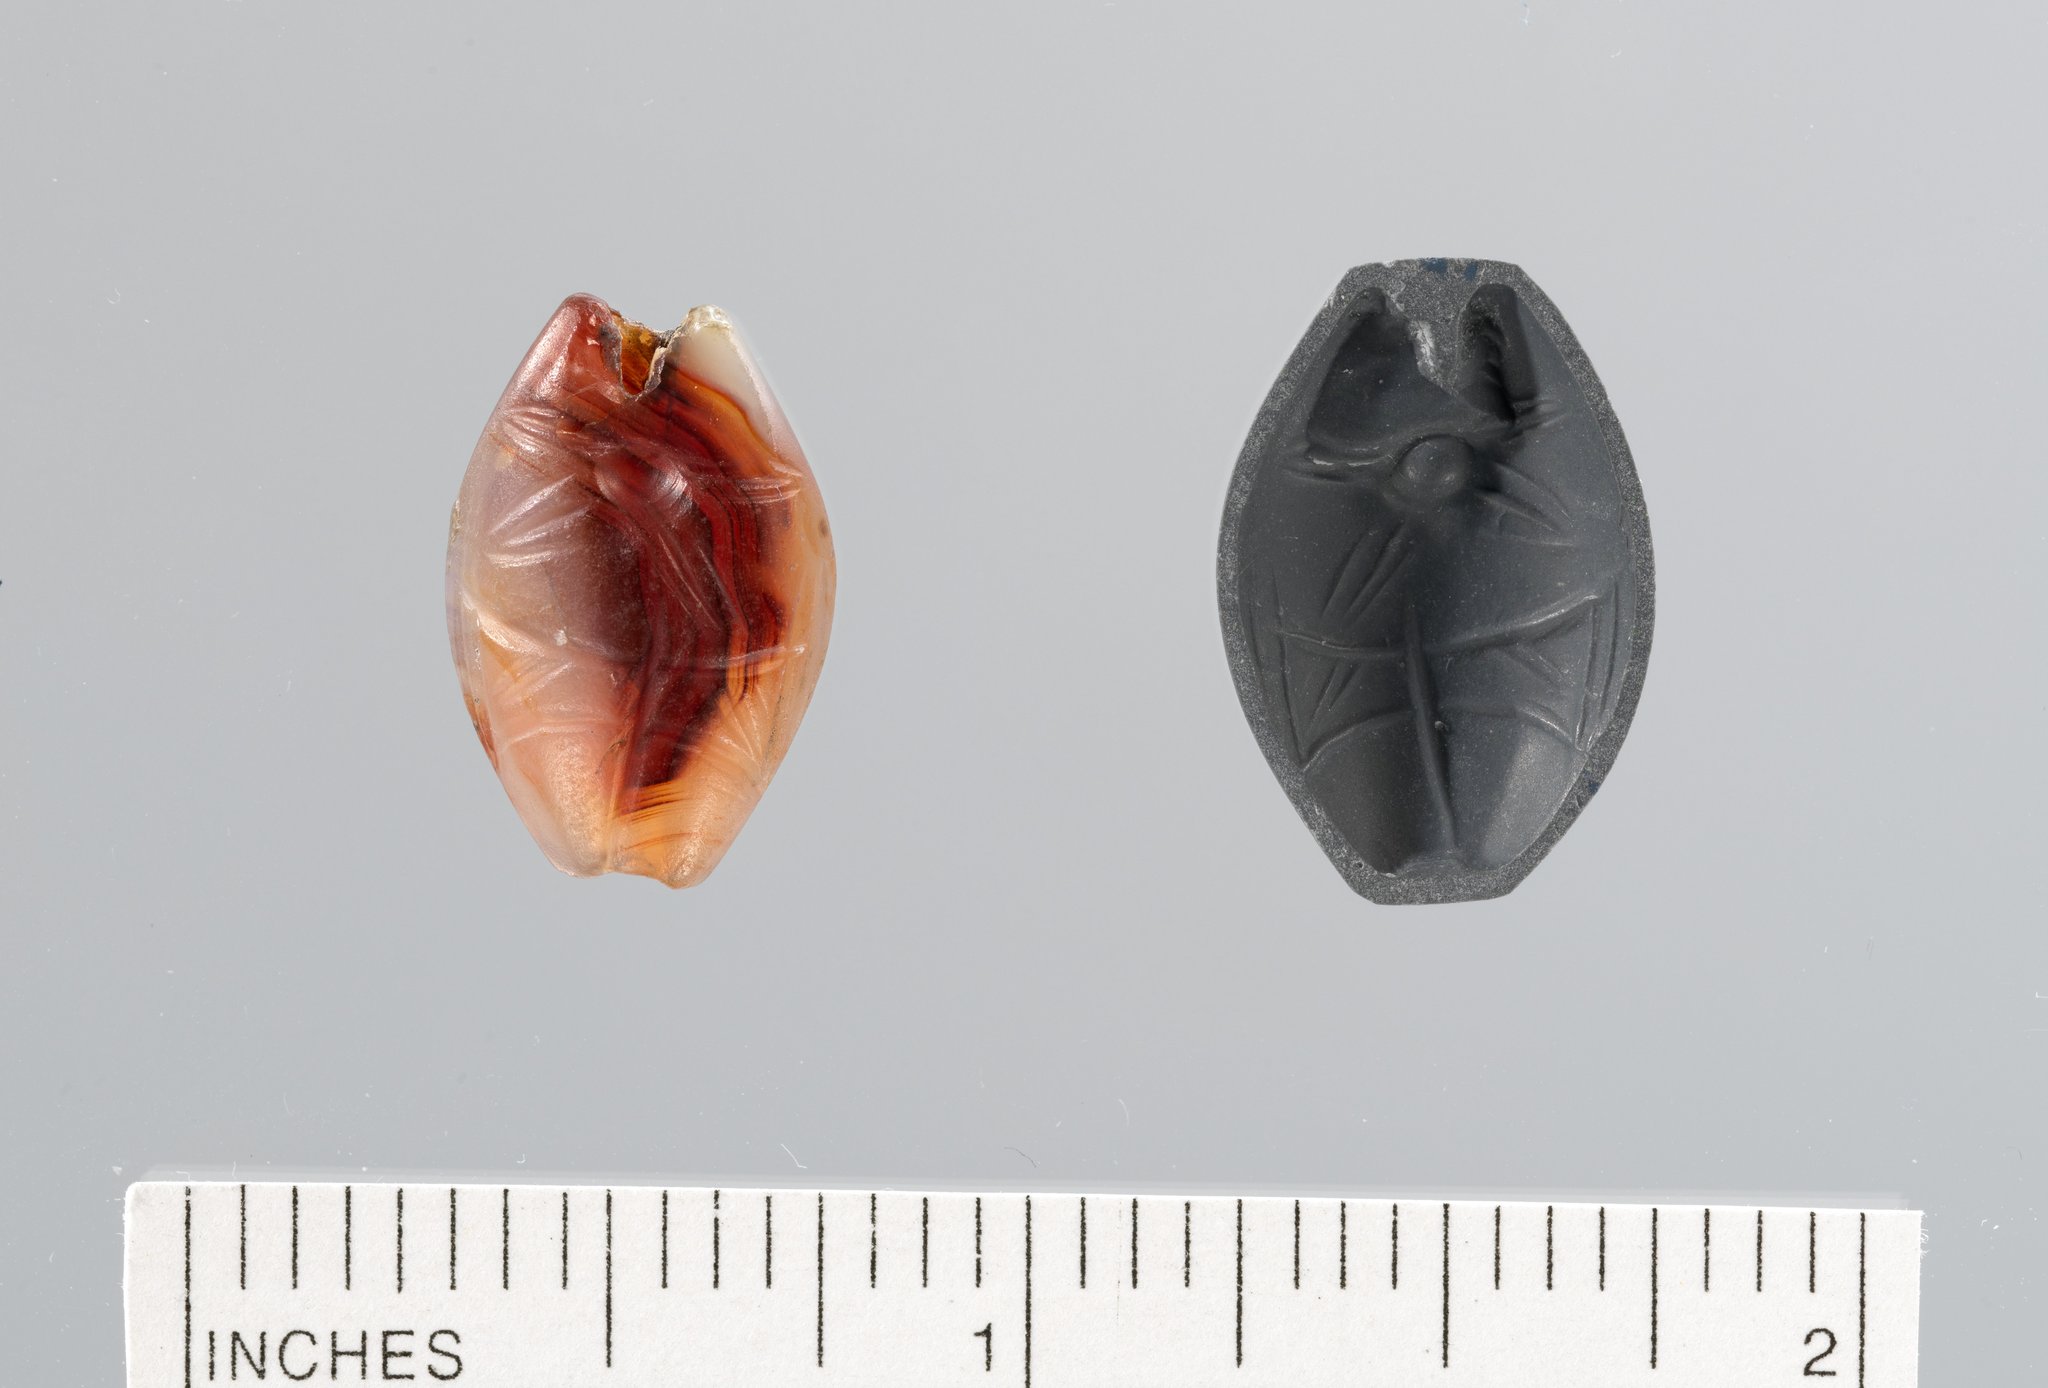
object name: seal, amygdaloid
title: Agate Amygdaloid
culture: minoan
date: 1650-1500 BCE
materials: stone